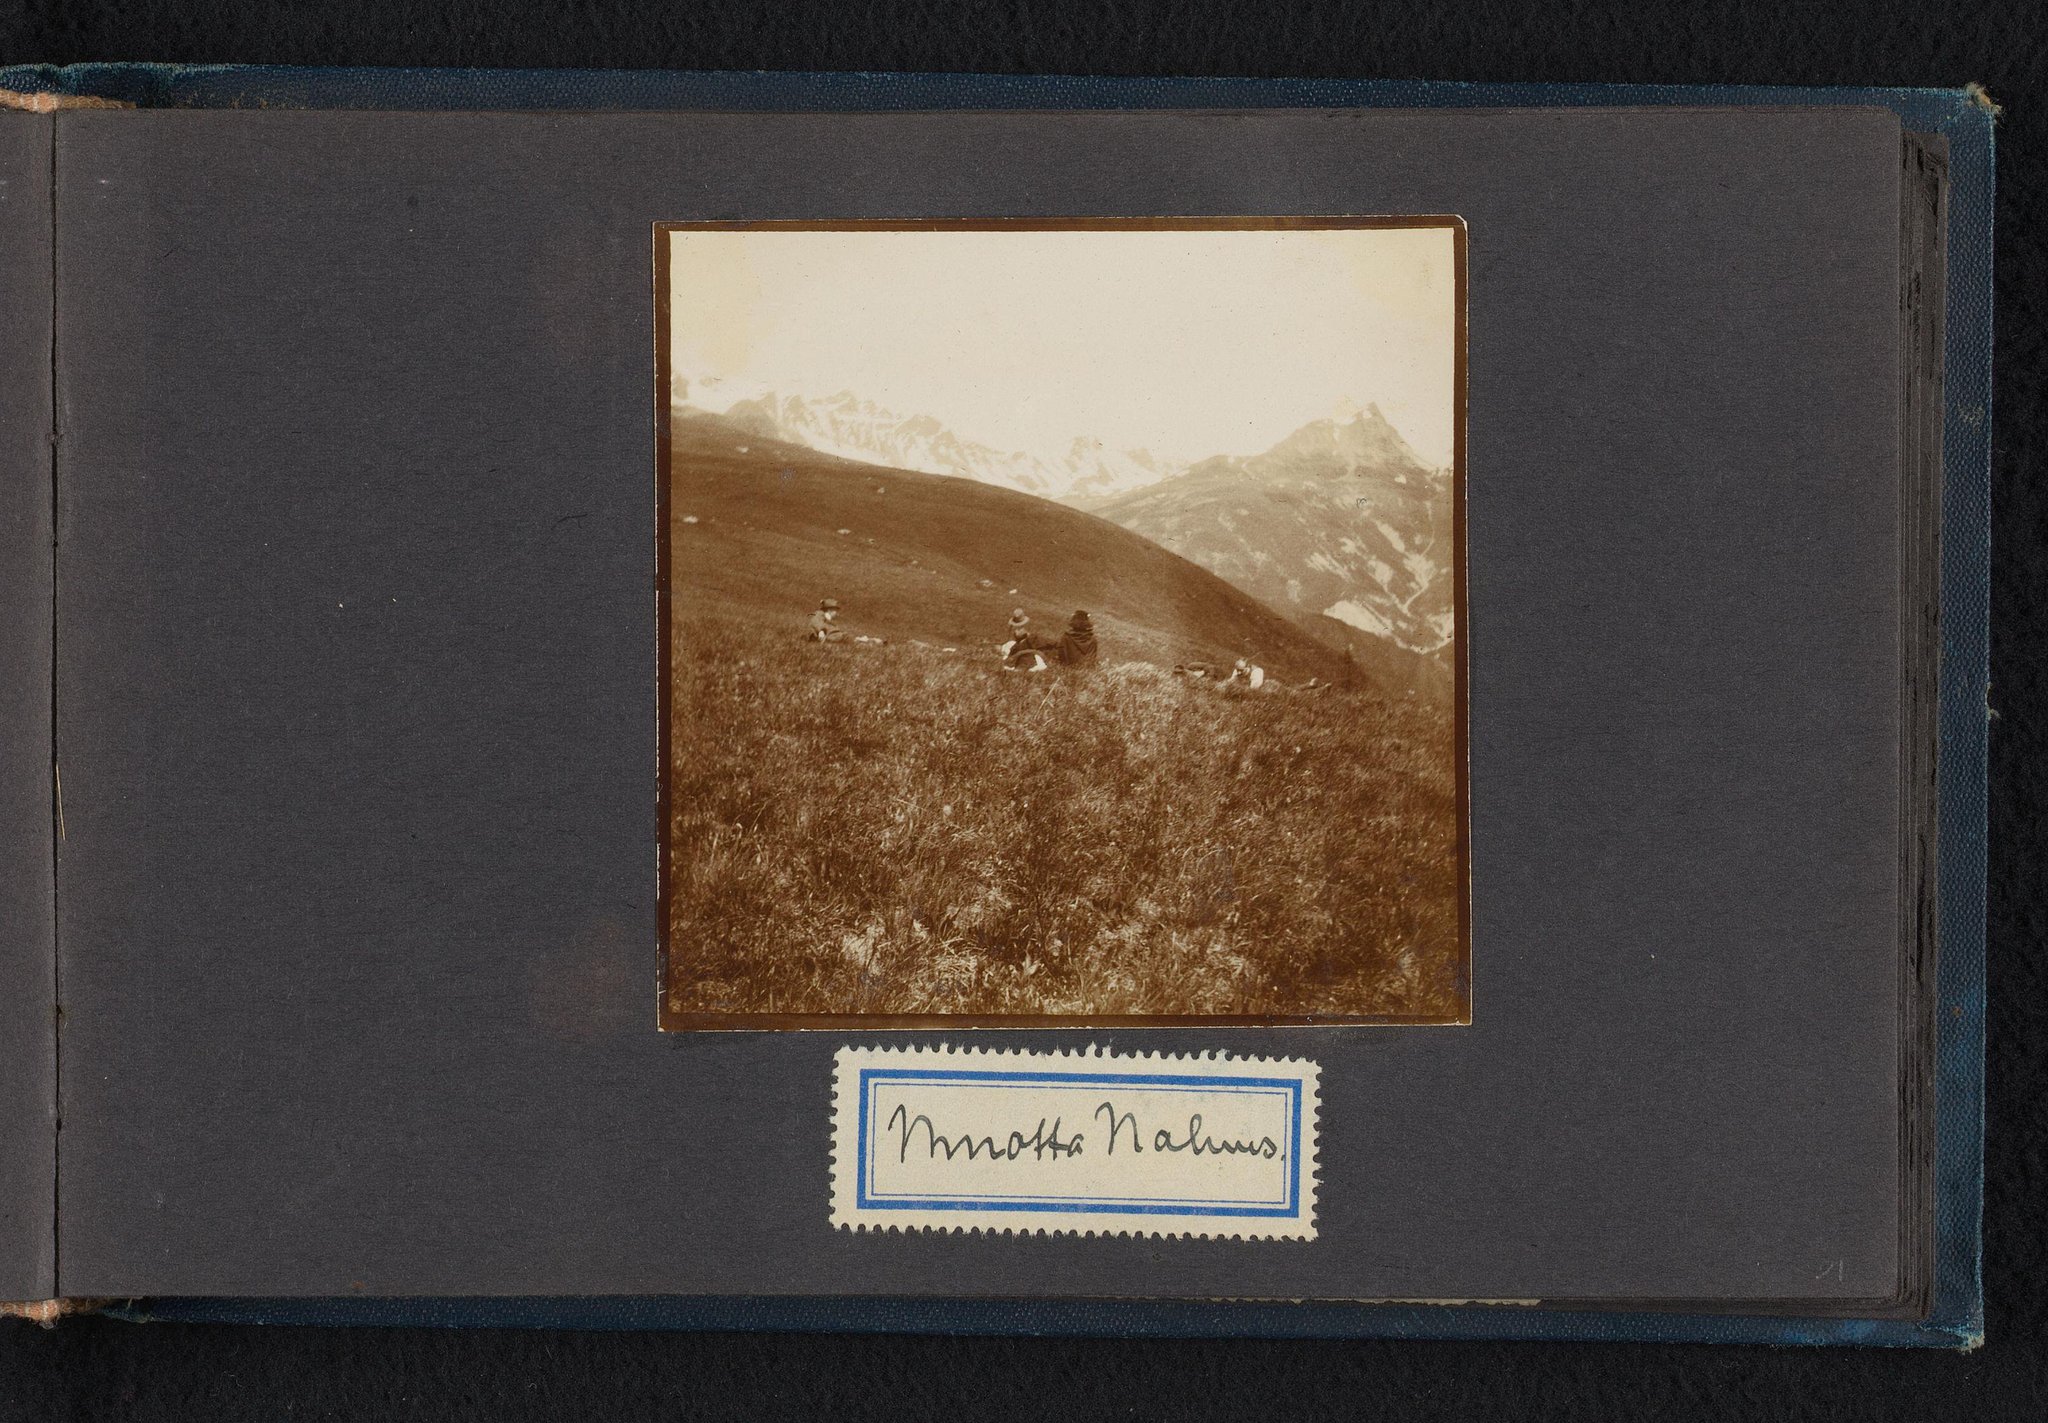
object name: photograph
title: Bergwandeling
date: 1913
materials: paper, photographic support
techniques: gelatin silver print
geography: switzerland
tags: else wachenheimer-moos, the family travelling, on holiday, walking, hiking (recreation), switzerland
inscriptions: inscription: ‘Motta Naluns’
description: Albumblad met een foto van Else met een rustend gezelschap tijdens een wandeling, in Zwitserland. Onderdeel van het fotoalbum van Else Wachenheimer-Moos en haar broers Arthur en Willy Moos en anderen in de periode 1913-1918.